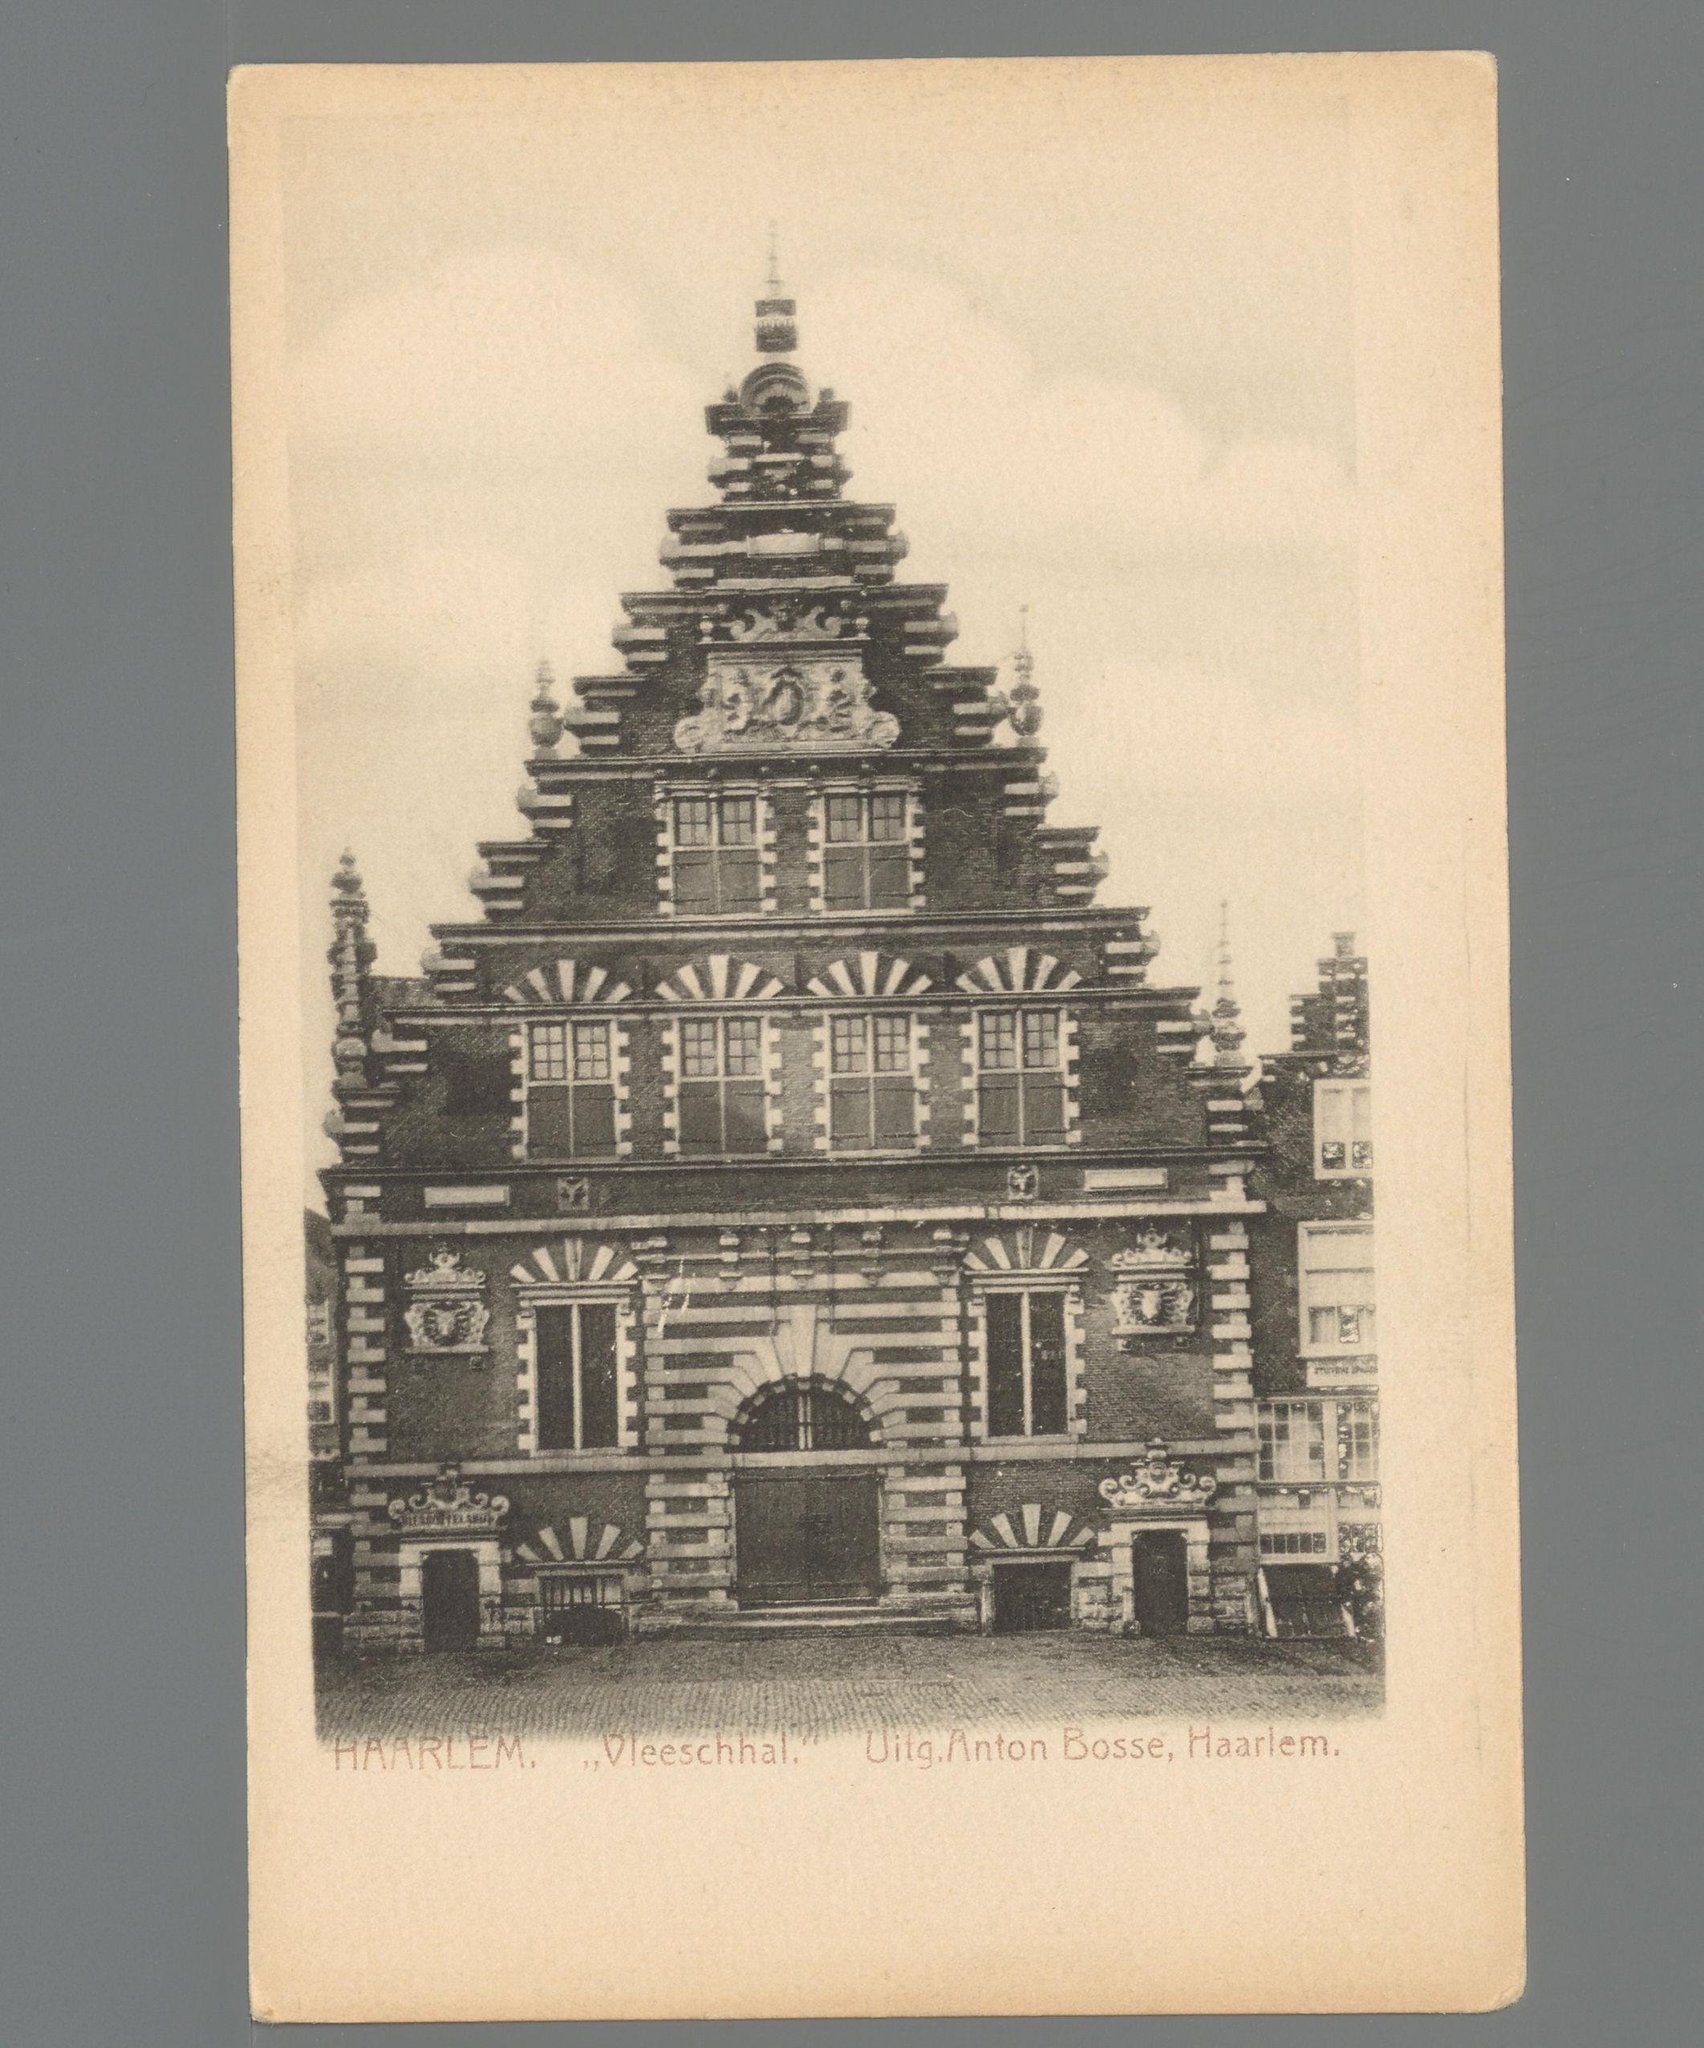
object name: photomechanical print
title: Haarlem. "Vleeschhal."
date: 1892-1905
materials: cardboard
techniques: photograph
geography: amsterdam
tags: city-view, and landscape with man-made constructions, monument, statue, market, haarlem